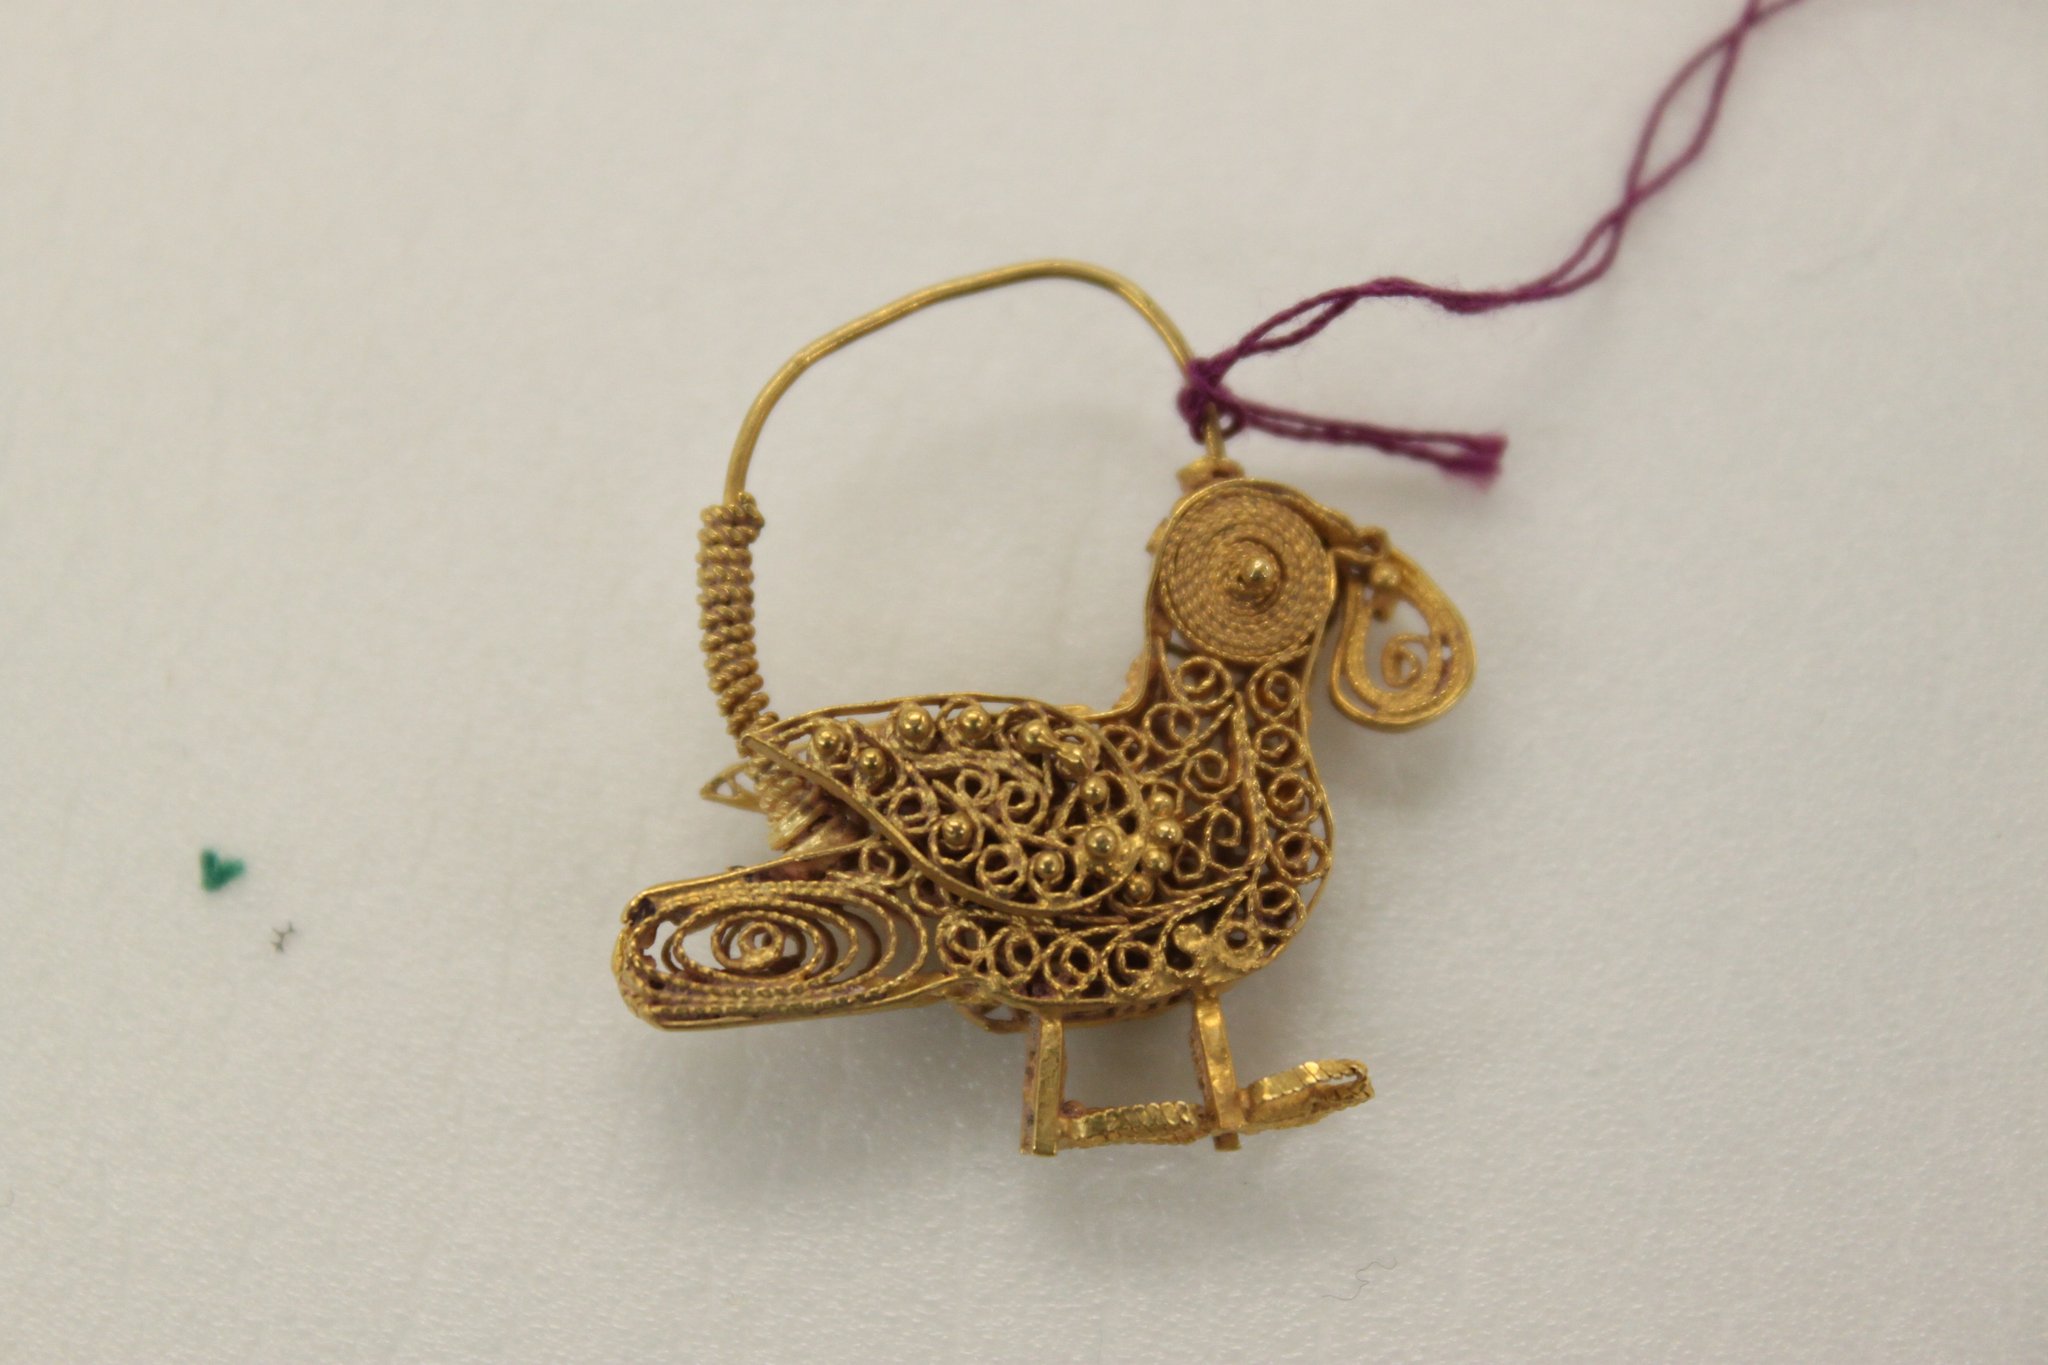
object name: earring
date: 1001-1200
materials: gold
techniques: filigree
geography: iran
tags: birds